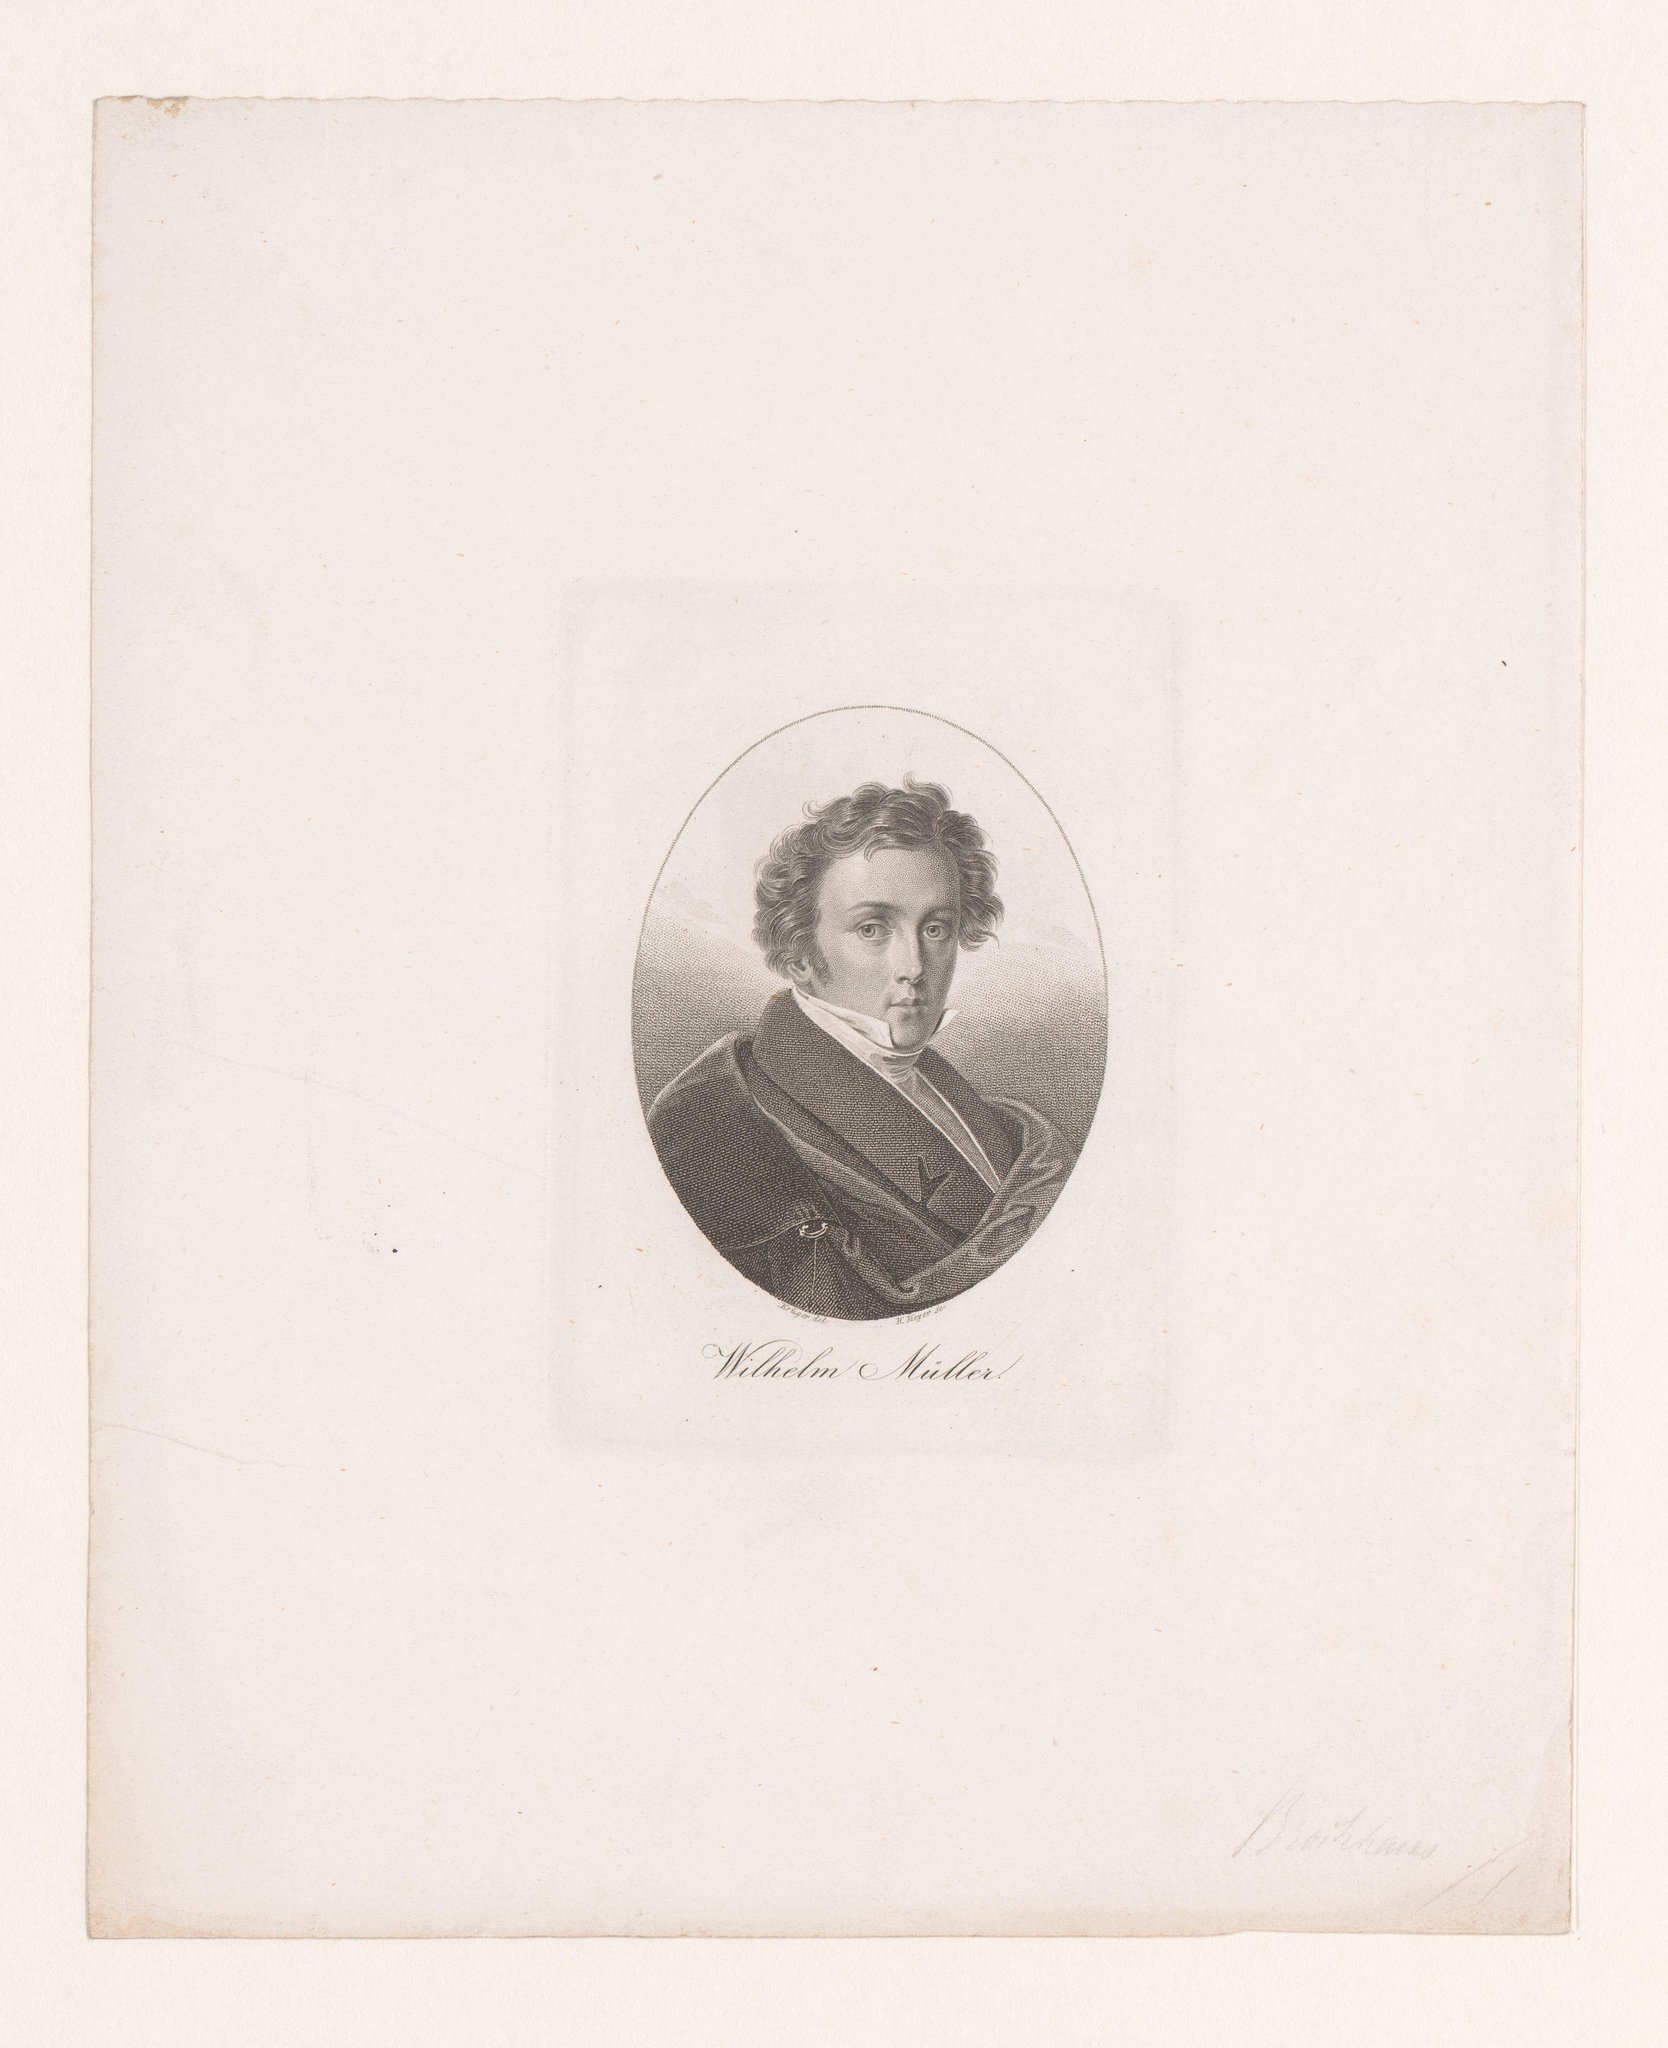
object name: print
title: Portret van Wilhelm Müller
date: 1812-1877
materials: paper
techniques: engraving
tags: historical persons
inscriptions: collector's mark: Lugt 2228